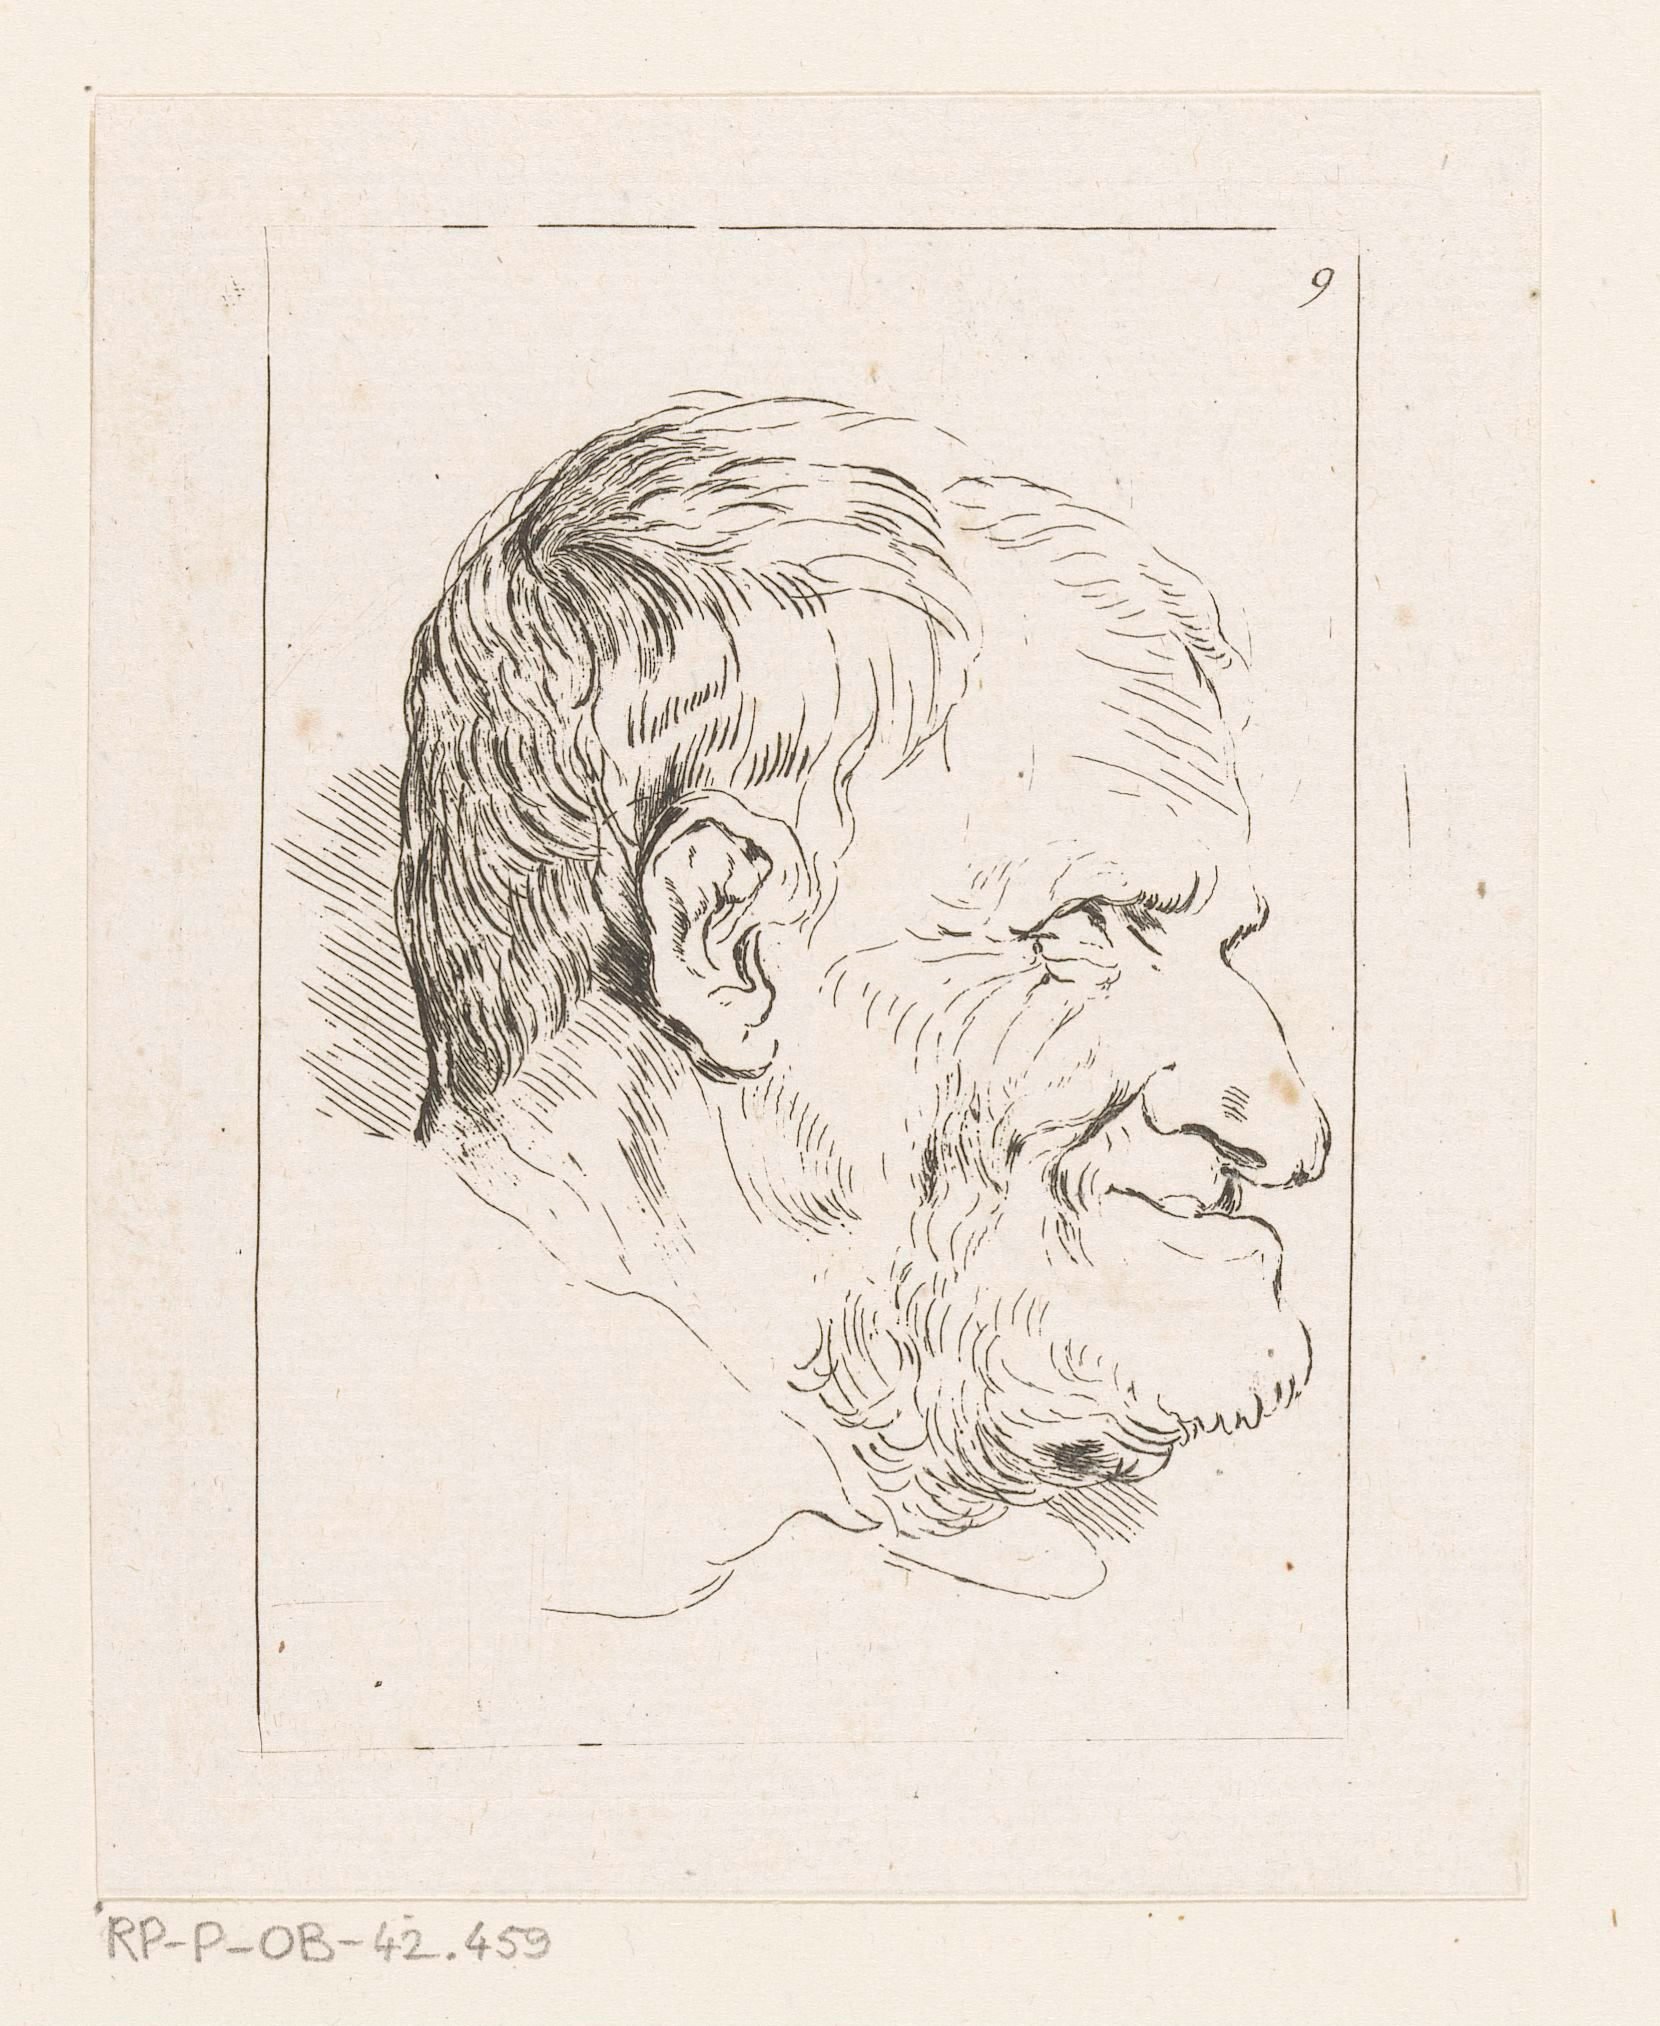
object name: print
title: Recueil de Testes d'Antoine Van Dyck (...)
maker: anne claude philippe caylus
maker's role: print maker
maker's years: 1692-1765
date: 1735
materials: paper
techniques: etching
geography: france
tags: head (human), laughing, old man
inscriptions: collector's mark: Lugt 240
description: Prent uit een serie van 31 prenten naar getekende hoofden door Van Dyck, plus een titelprent naar Bouchardon, getiteld: "Recueil de Testes d'Antoine Van Dyck tirées du Cabinet de M. Crozat et gravées par M. le C. de C.".